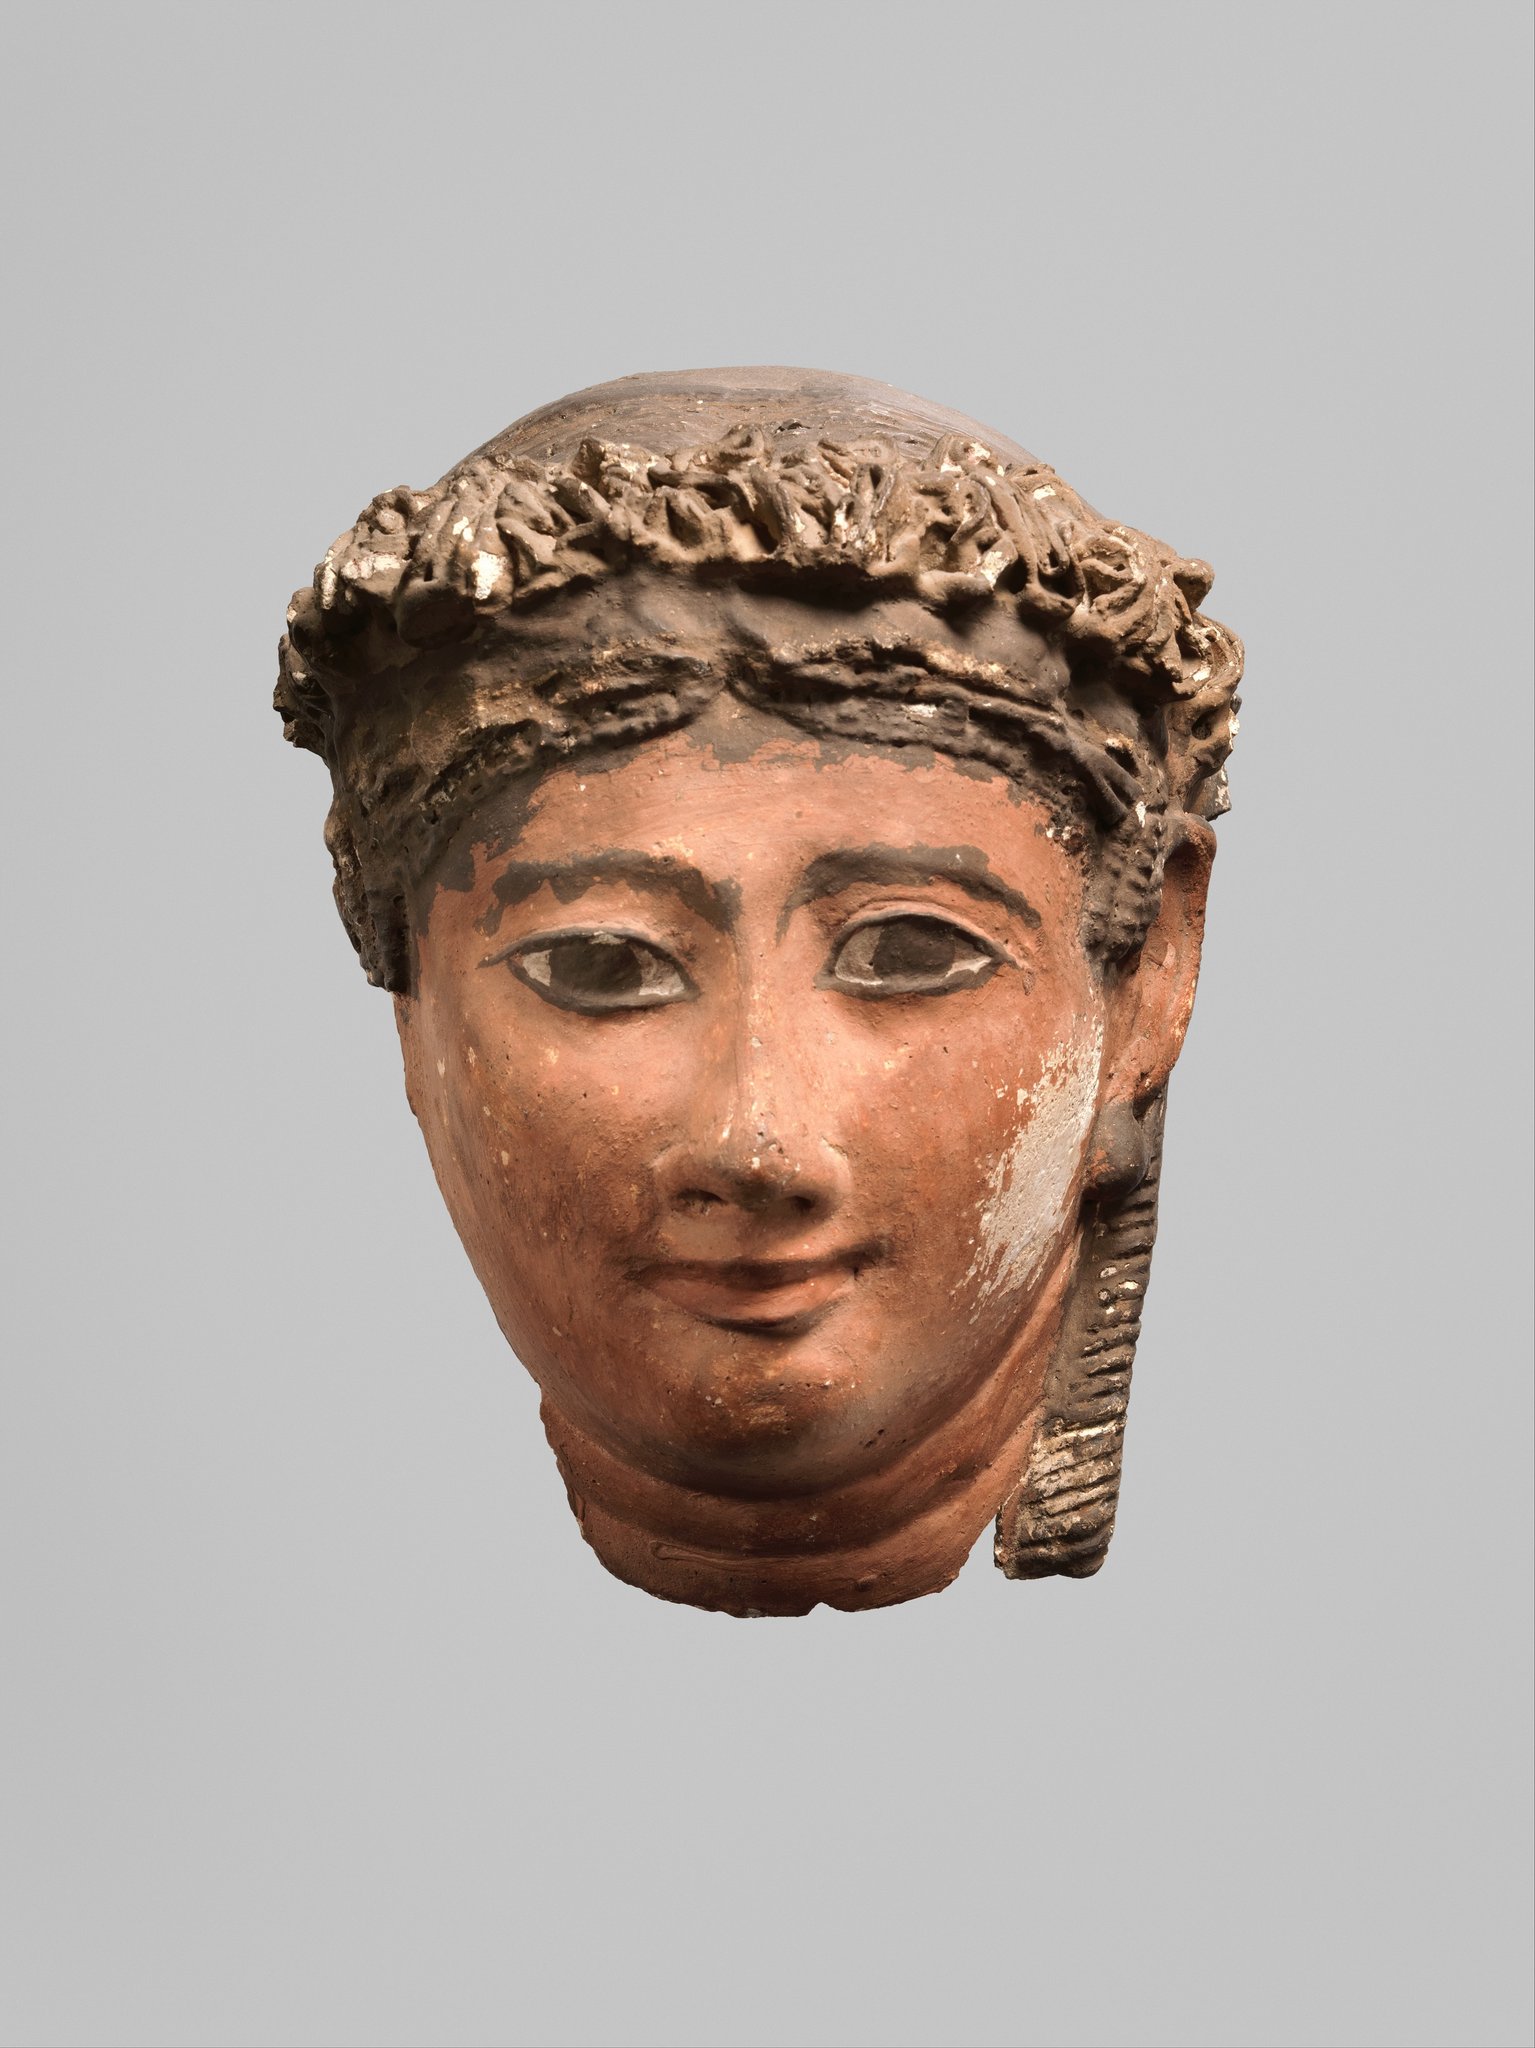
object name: mask, woman, corkscrew lock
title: Mask of a woman with corkscrew locks and ball earrings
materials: paint, plaster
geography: egypt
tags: masks